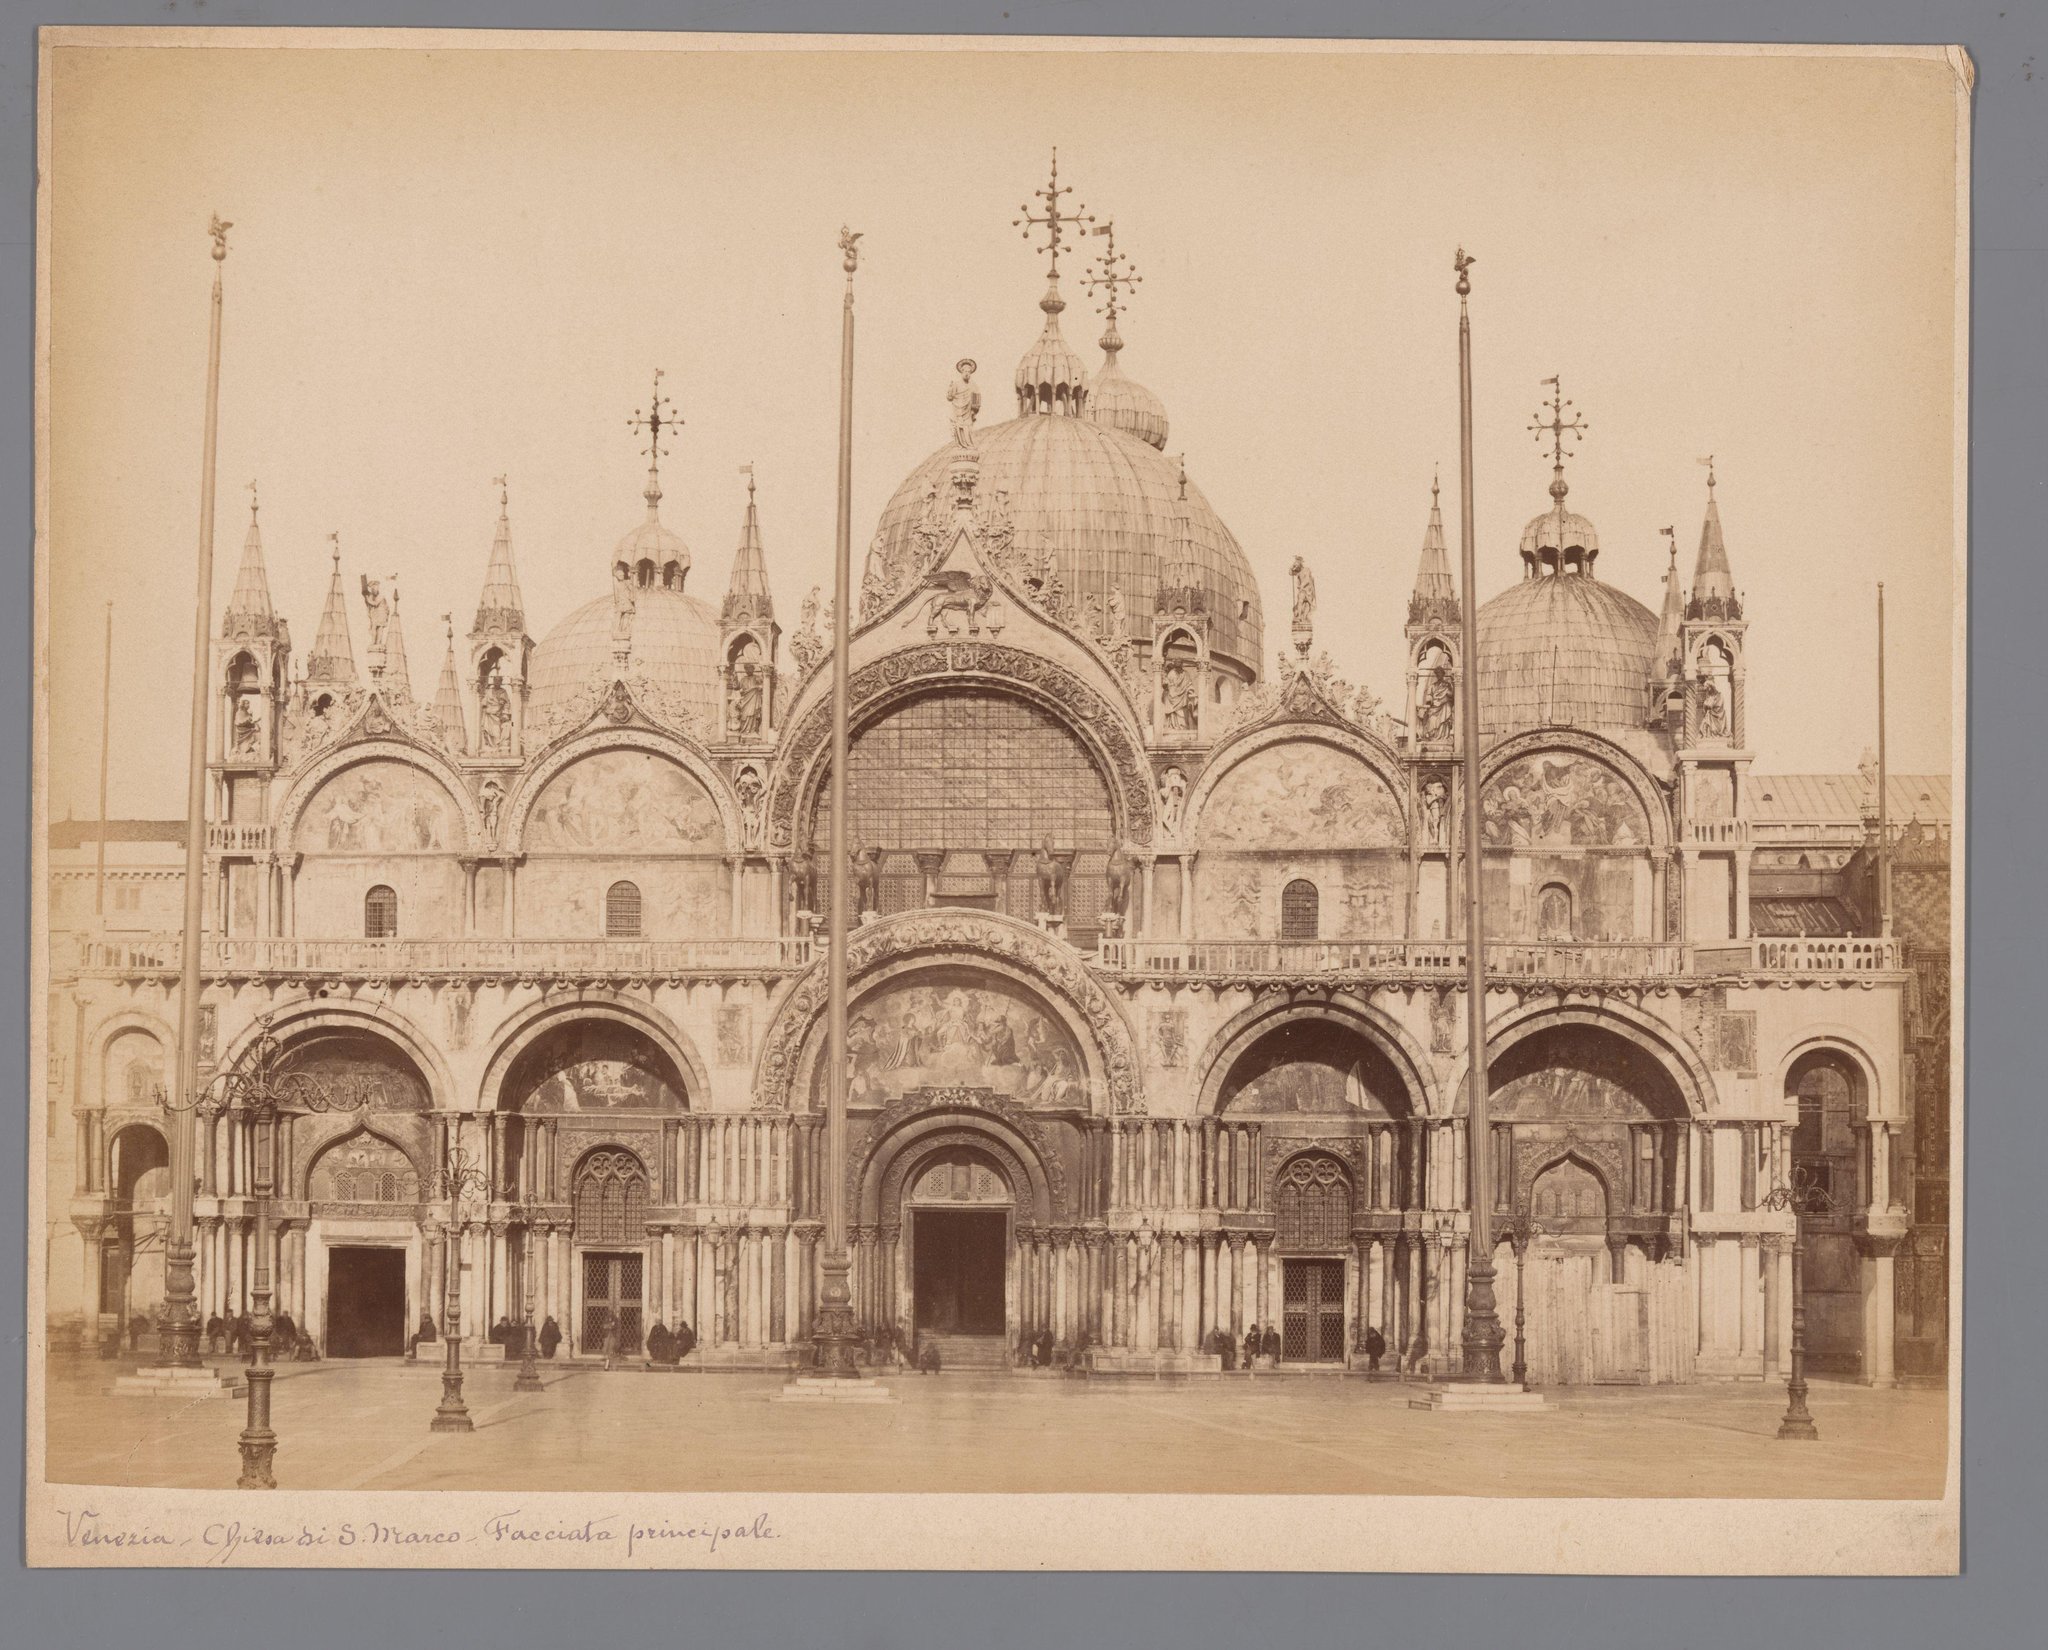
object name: photograph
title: Venezia - Chiesa di S. Marco - Facciata principale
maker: Anonymous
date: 1851-1900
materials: cardboard, paper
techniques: albumen print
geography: venice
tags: parts of church exterior and annexes: west façade, venice